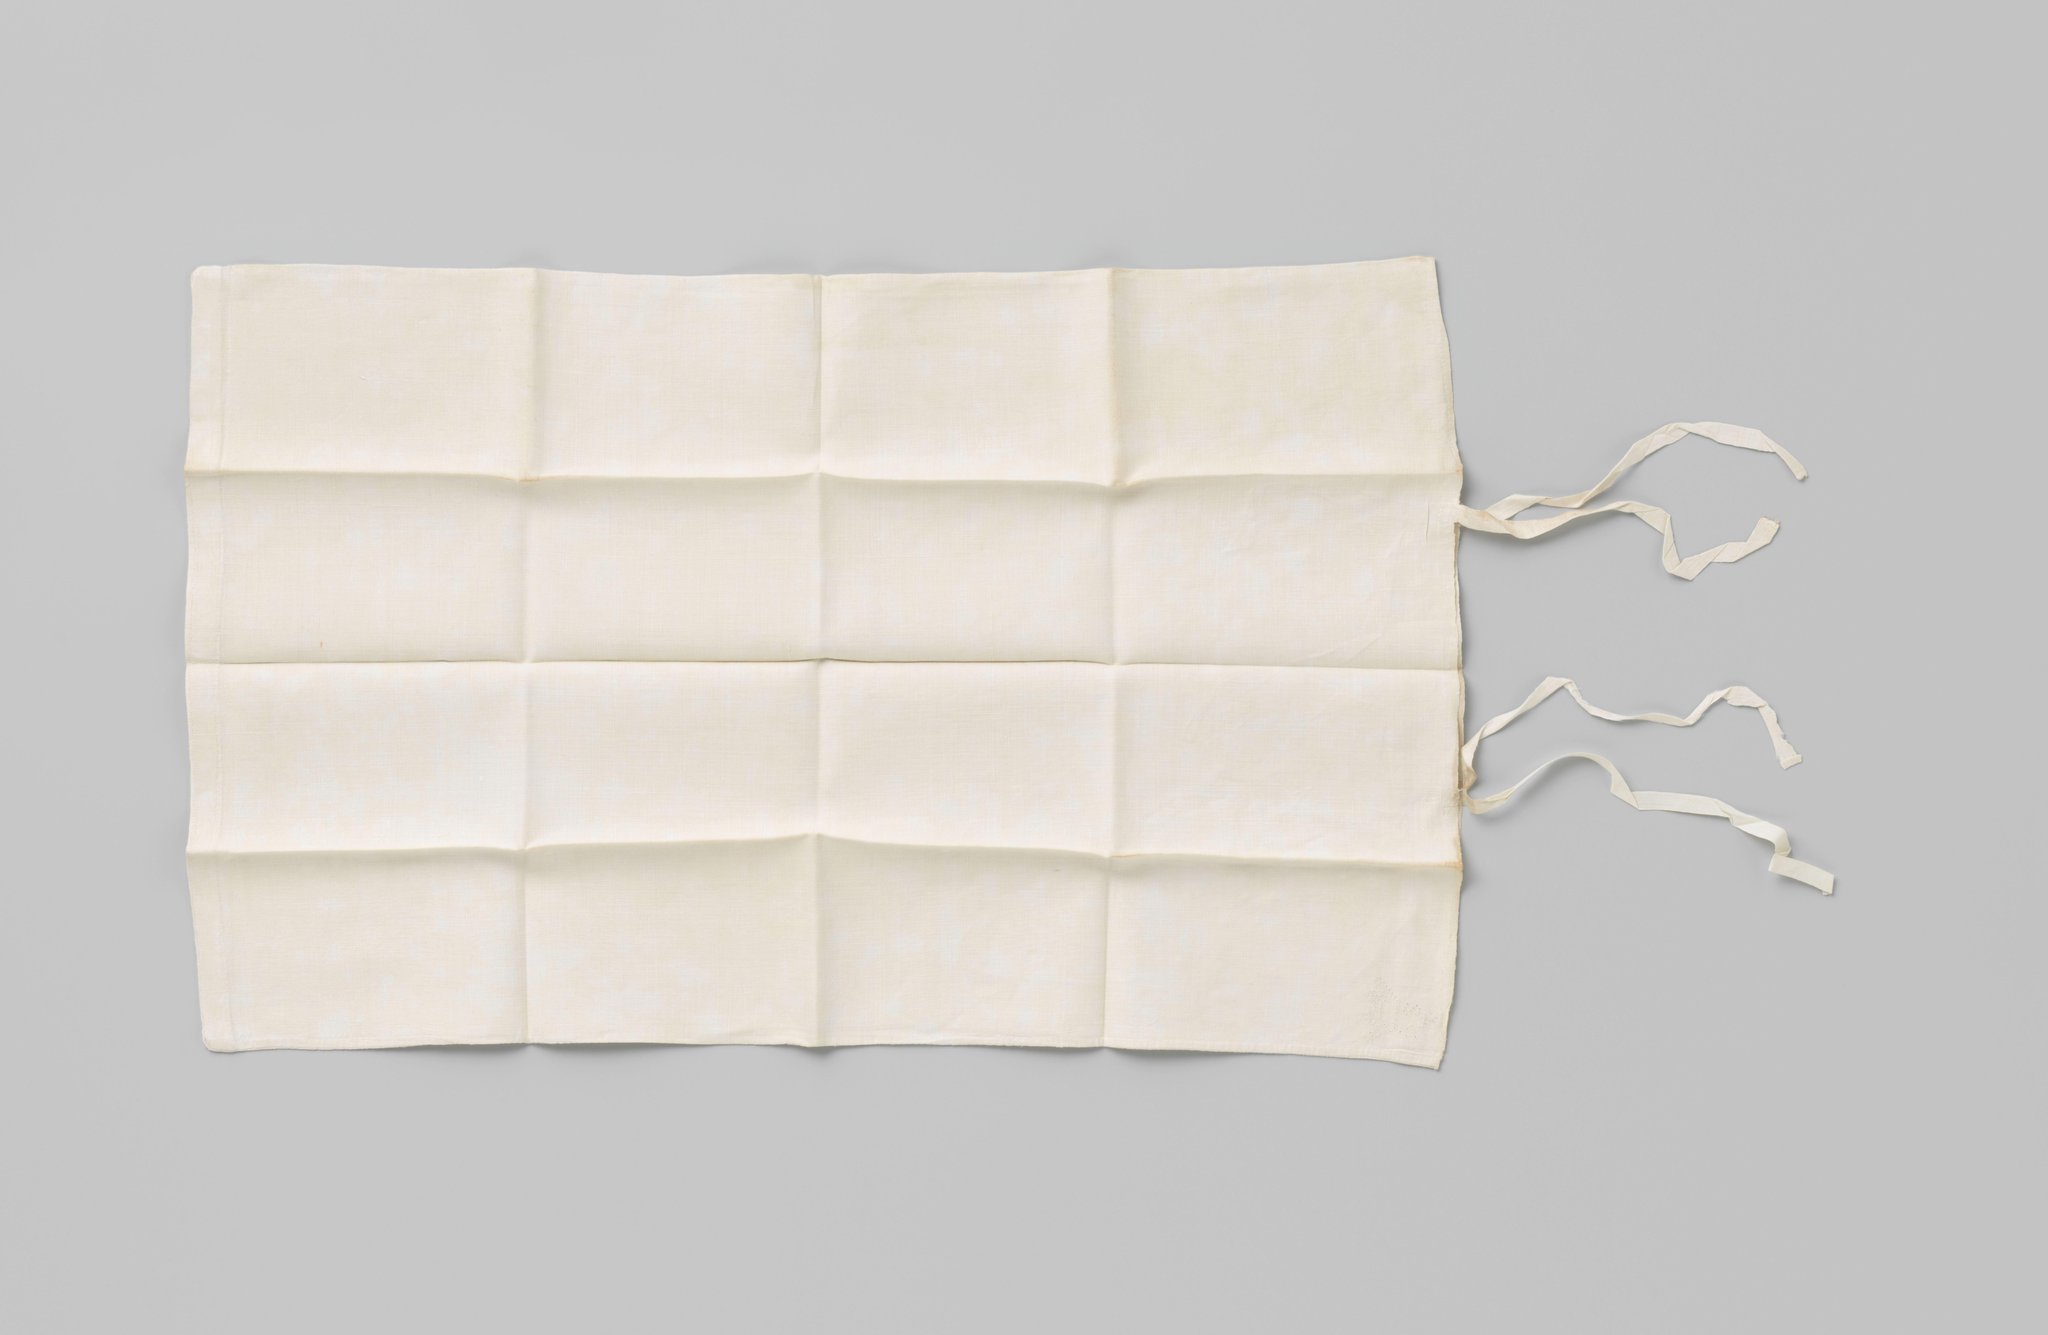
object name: lendensloop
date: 1692-1735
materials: linen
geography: northern netherlands